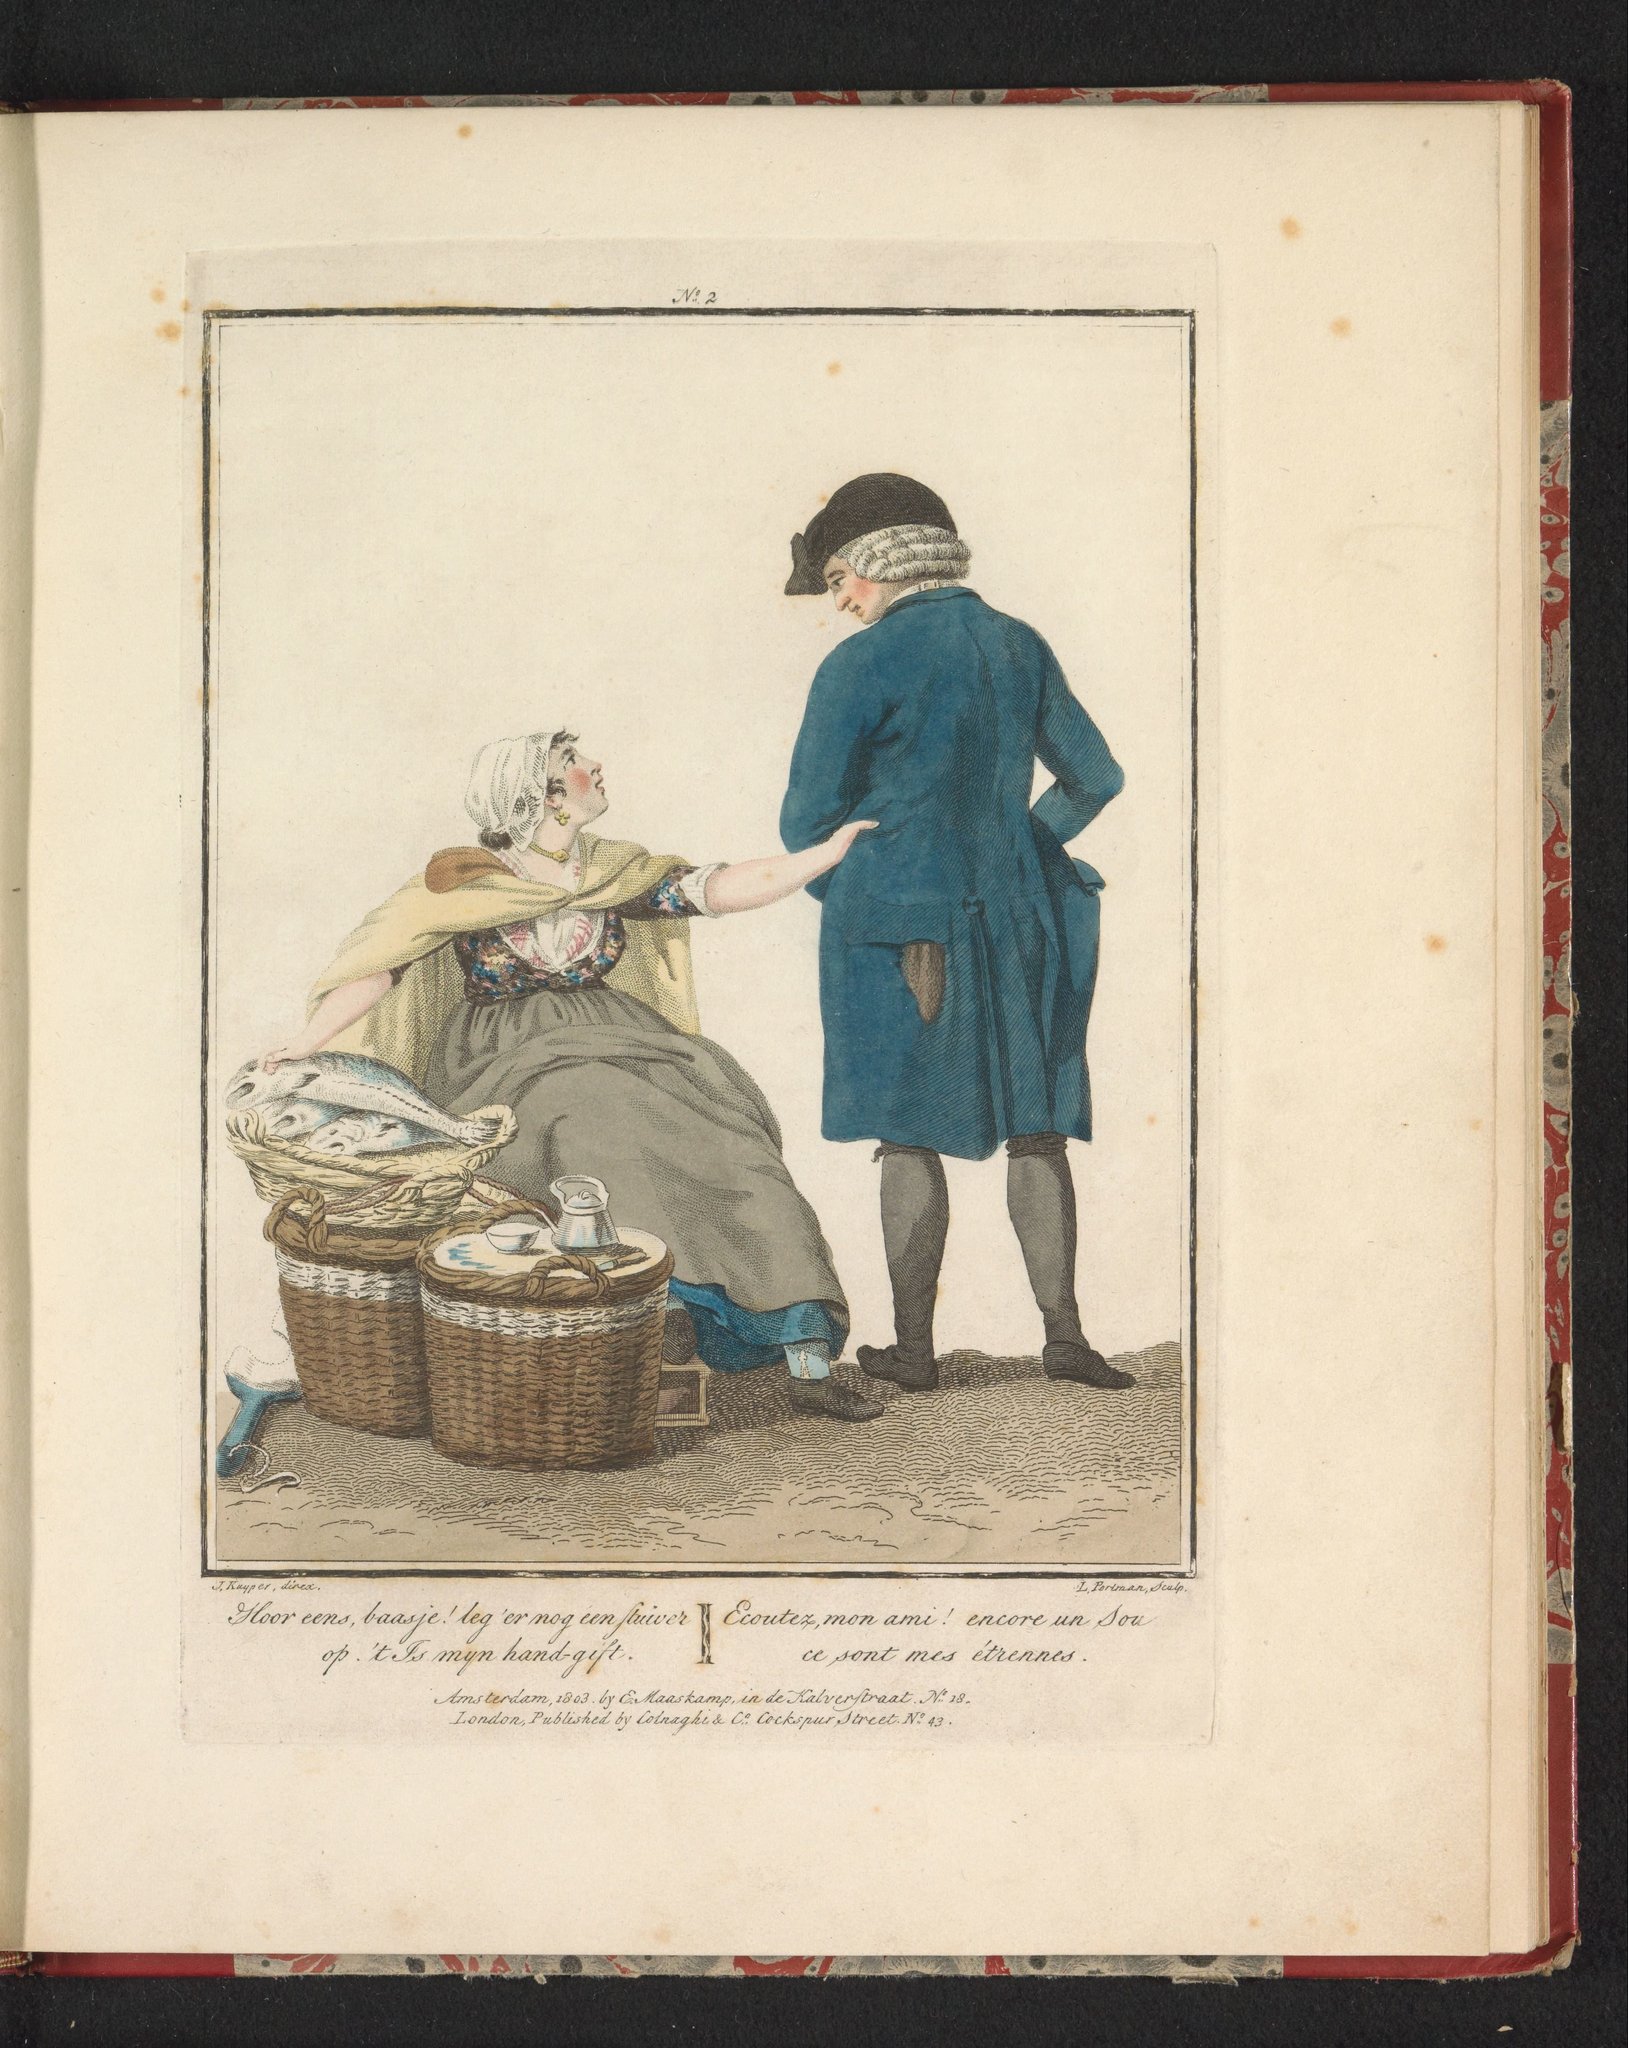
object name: print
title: Hoor eens, baasje! leg 'er nog een stuiver op. 't Is mijn hand-gift / Ecoutez, mon ami! encore un Sou ce sont mes étrennes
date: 1803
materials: paper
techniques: etching, hand coloring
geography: netherlands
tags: street-trader - bb - women engaged in trade and commerce, fishes, clothes, costume (+ women's clothes), folk costume, regional costume, amsterdam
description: Een Amsterdamse visverkoopster zit naast haar manden met vis. Ze klampt een heer in blauwe jas aan om iets van haar te kopen. Eerste aflevering van vier platen, verschenen in 1803. Onderdeel van een gebonden uitgave van de reeks van twintig platen van Nederlandse klederdrachten in de Bataafse Republiek aan het begin van de negentiende eeuw door Maaskamp, ca. 1807.